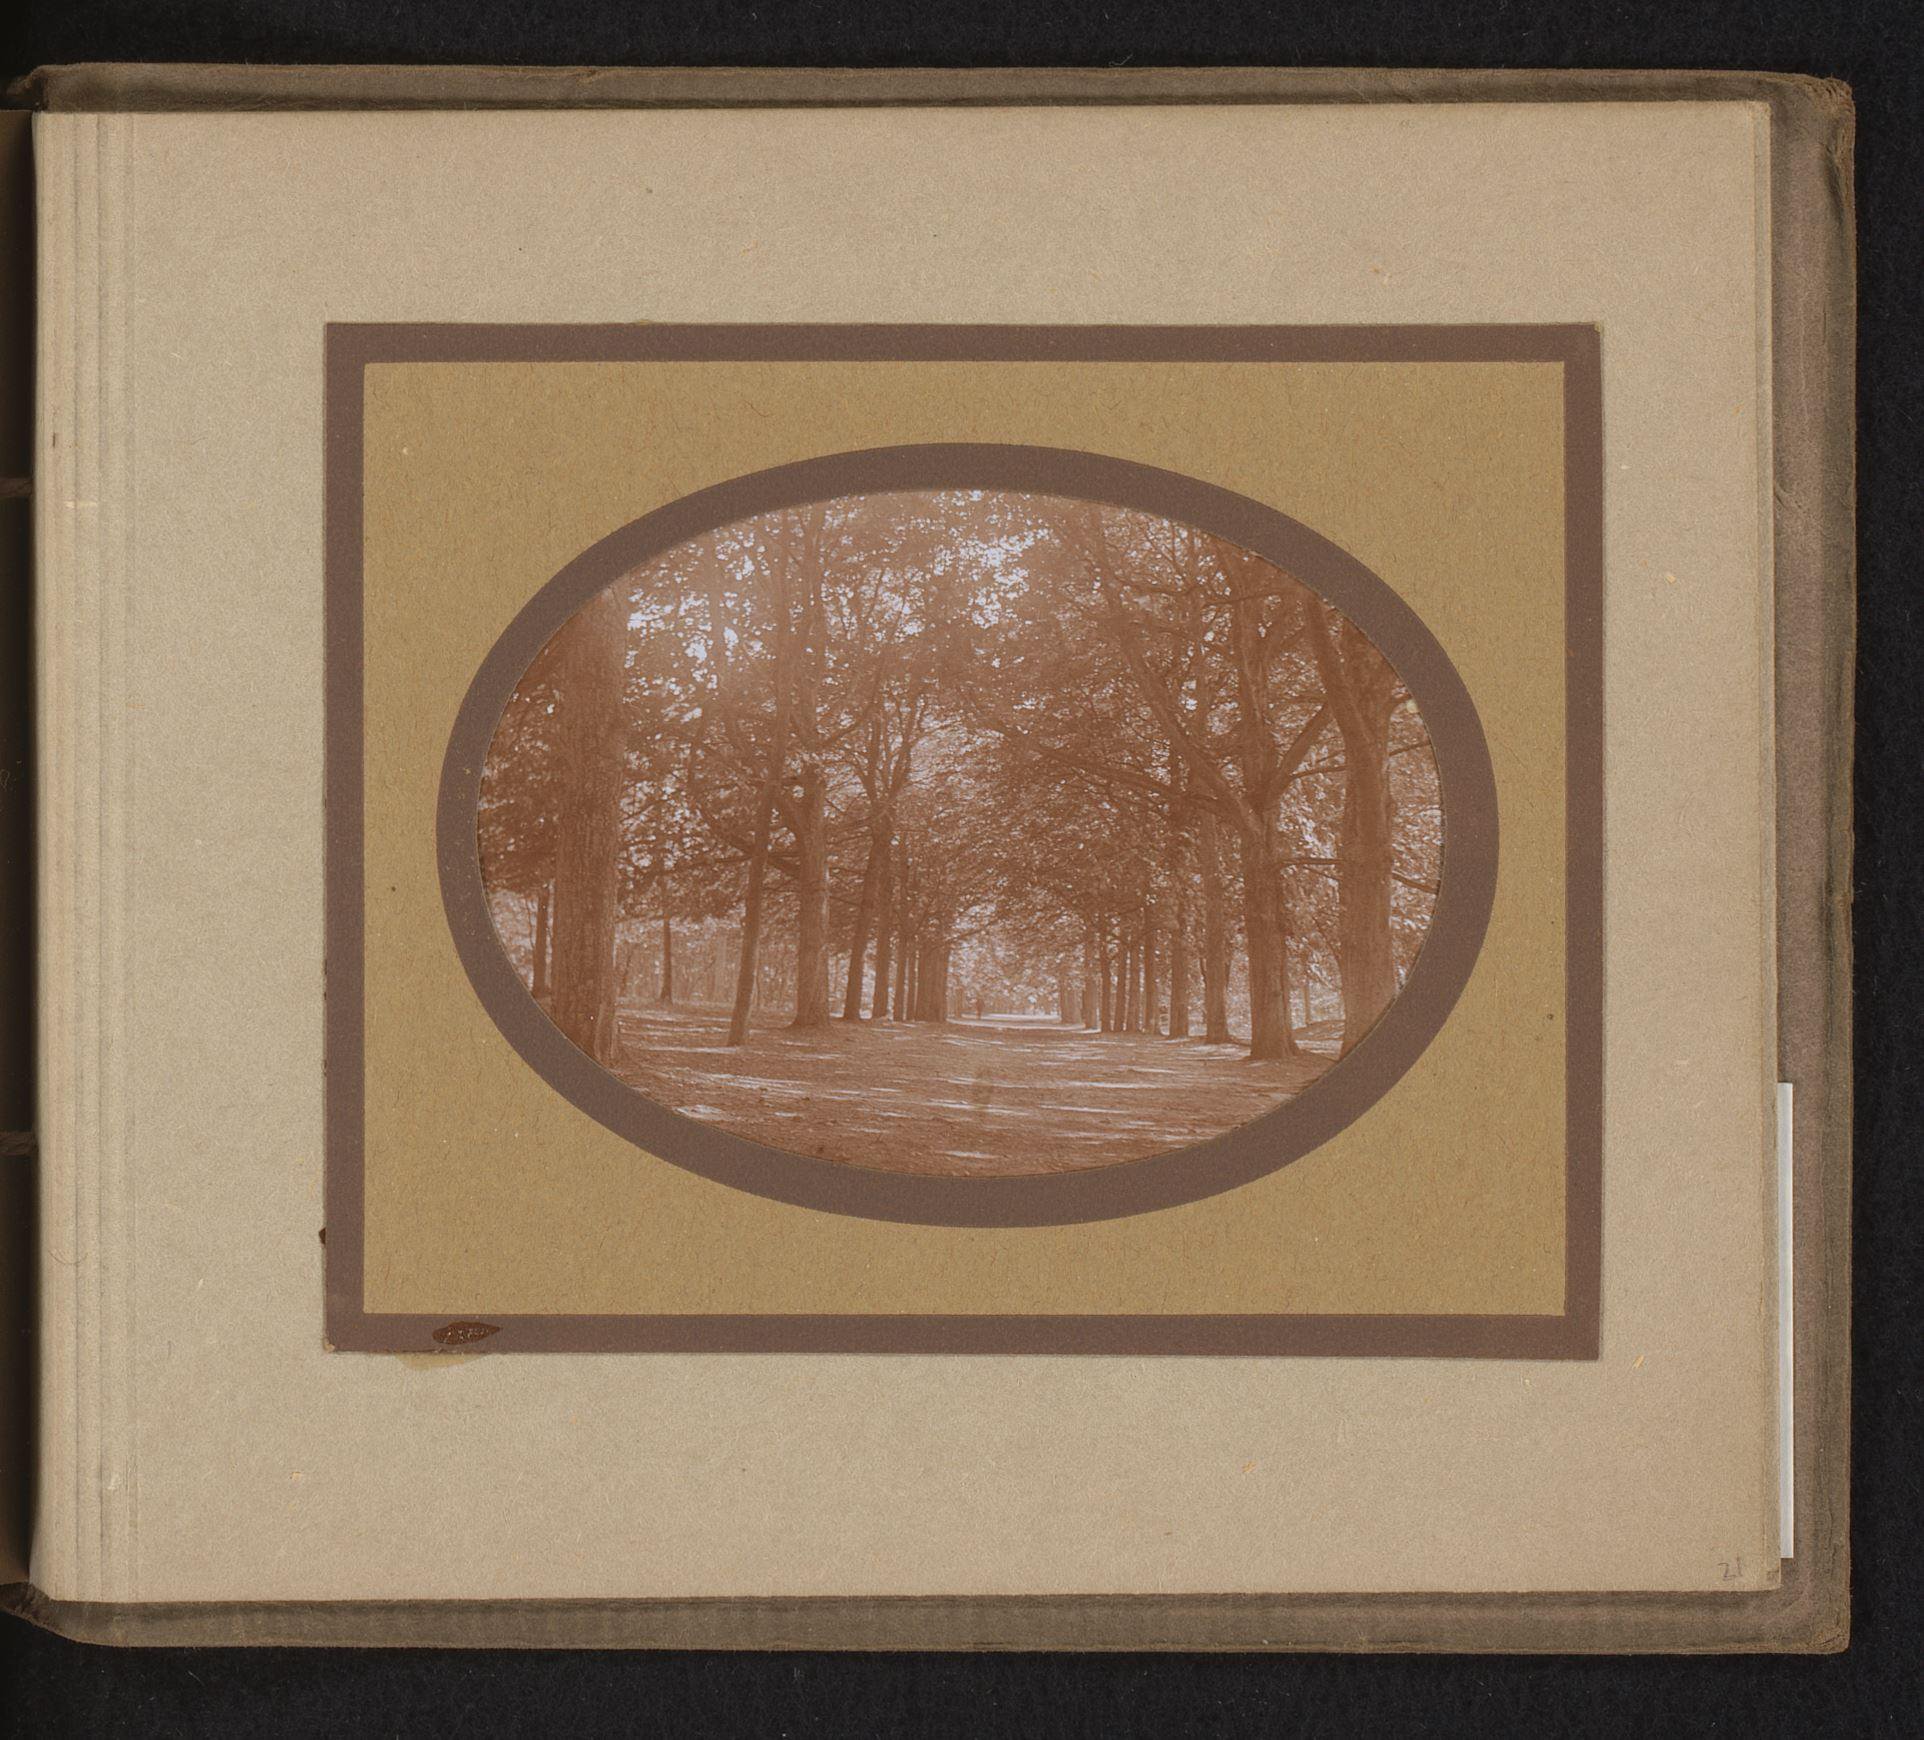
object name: photograph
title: Gezicht op een bospad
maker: Anonymous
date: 1900-1930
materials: photographic support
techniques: collodion silver print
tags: trees, forest path or lane